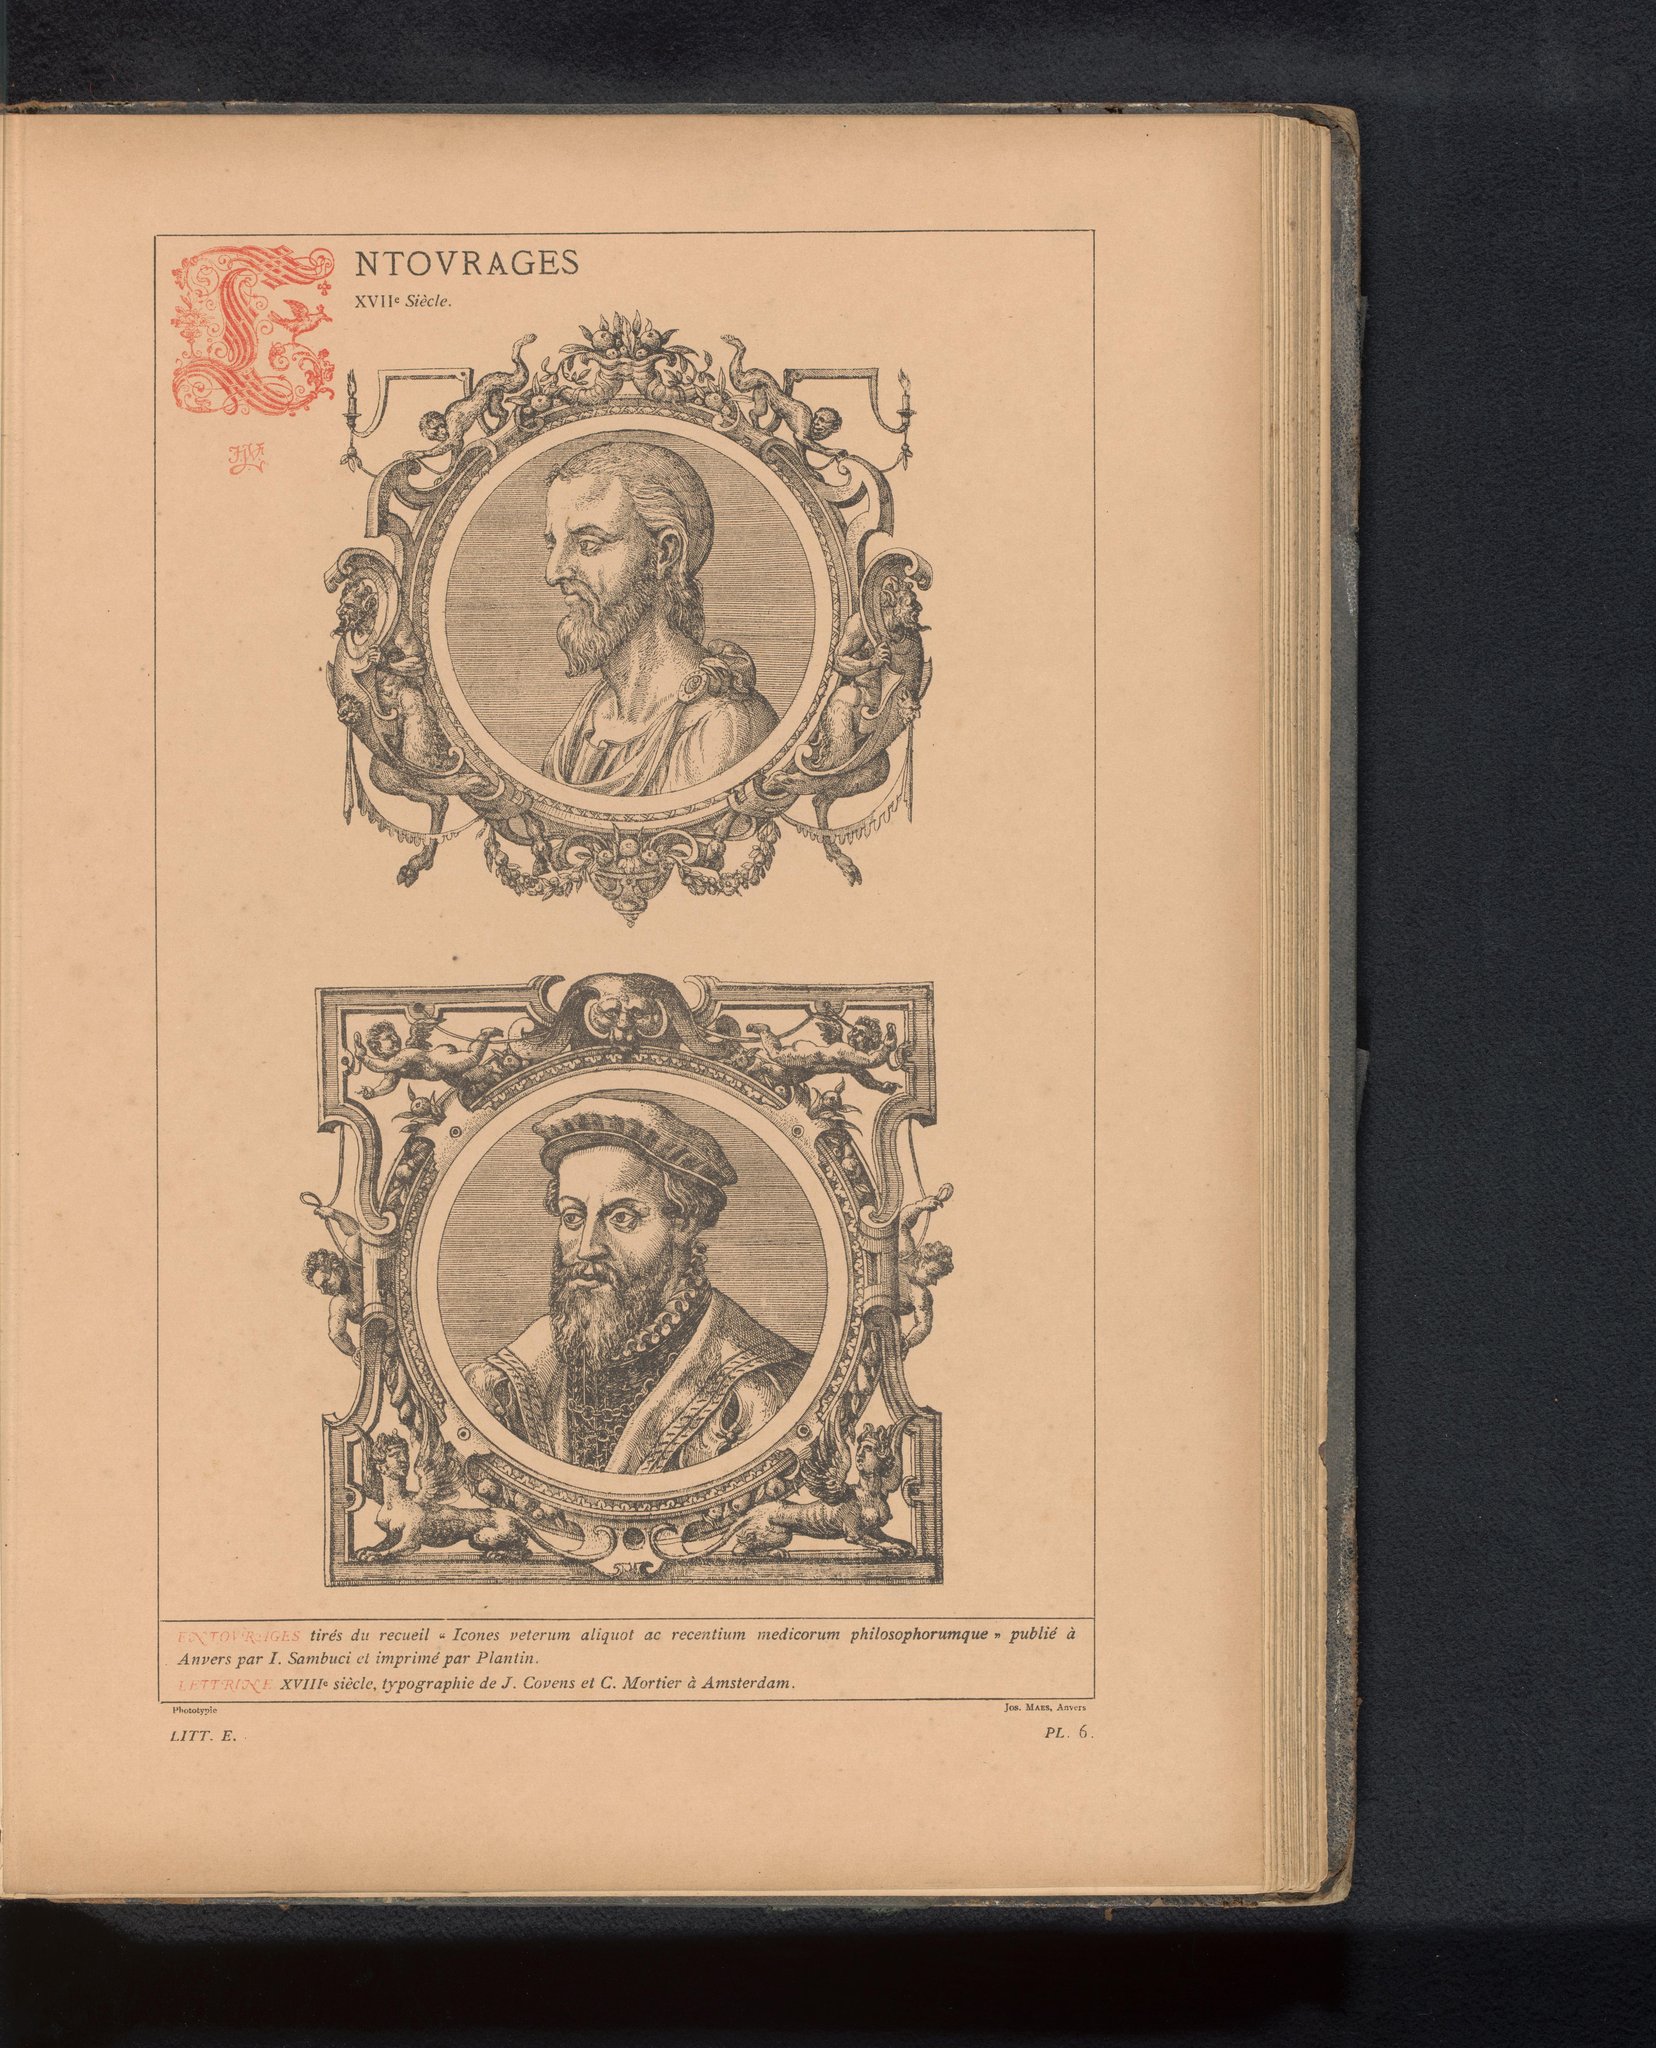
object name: reproduction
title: Entourages, XVIIe Siècle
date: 1875-1880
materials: paper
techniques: photolithography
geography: amsterdam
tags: fabulous animals (sometimes wrongly called 'grotesques'); 'mostri' (ripa), historical persons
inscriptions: monogram: ‘JJvY’, inscription: ‘ENTOURAGES tirés du (...)’, inscription: ‘LITT. E. - PL. 6.’